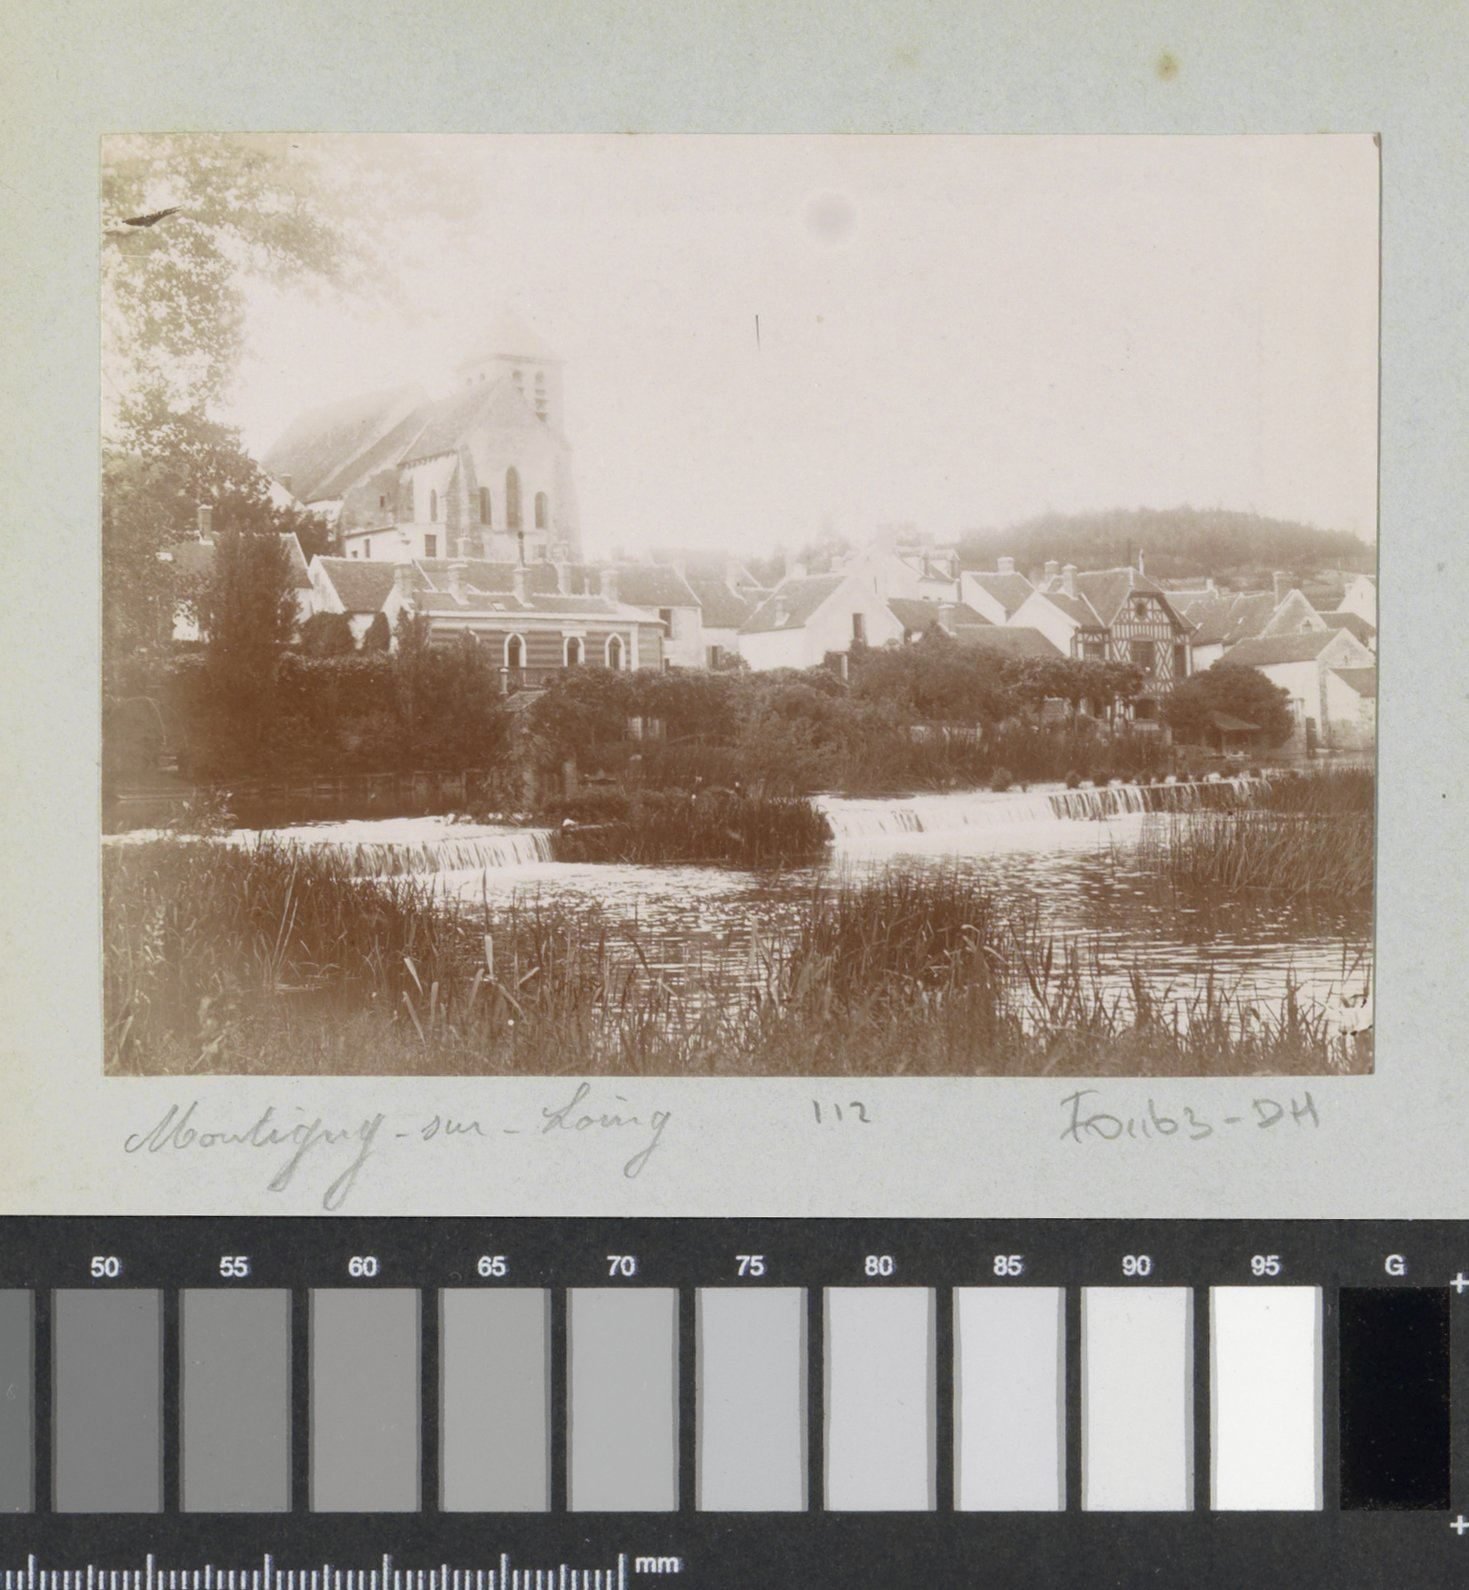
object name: photograph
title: Gezicht op Montigny-sur-Loing met stroomversnelling en kerk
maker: delizy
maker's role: manufacturer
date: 1897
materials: paper, photographic support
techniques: gelatin silver print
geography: montigny-sur-loing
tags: prospect of village, silhouette of village, rapids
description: Onderdeel van Fotoalbum van een Franse amateurfotograaf met opnames van uitstapjes in Frankrijk, Spanje, België, Luxemburg en Nederland, de eerste automobielen en autoraces.